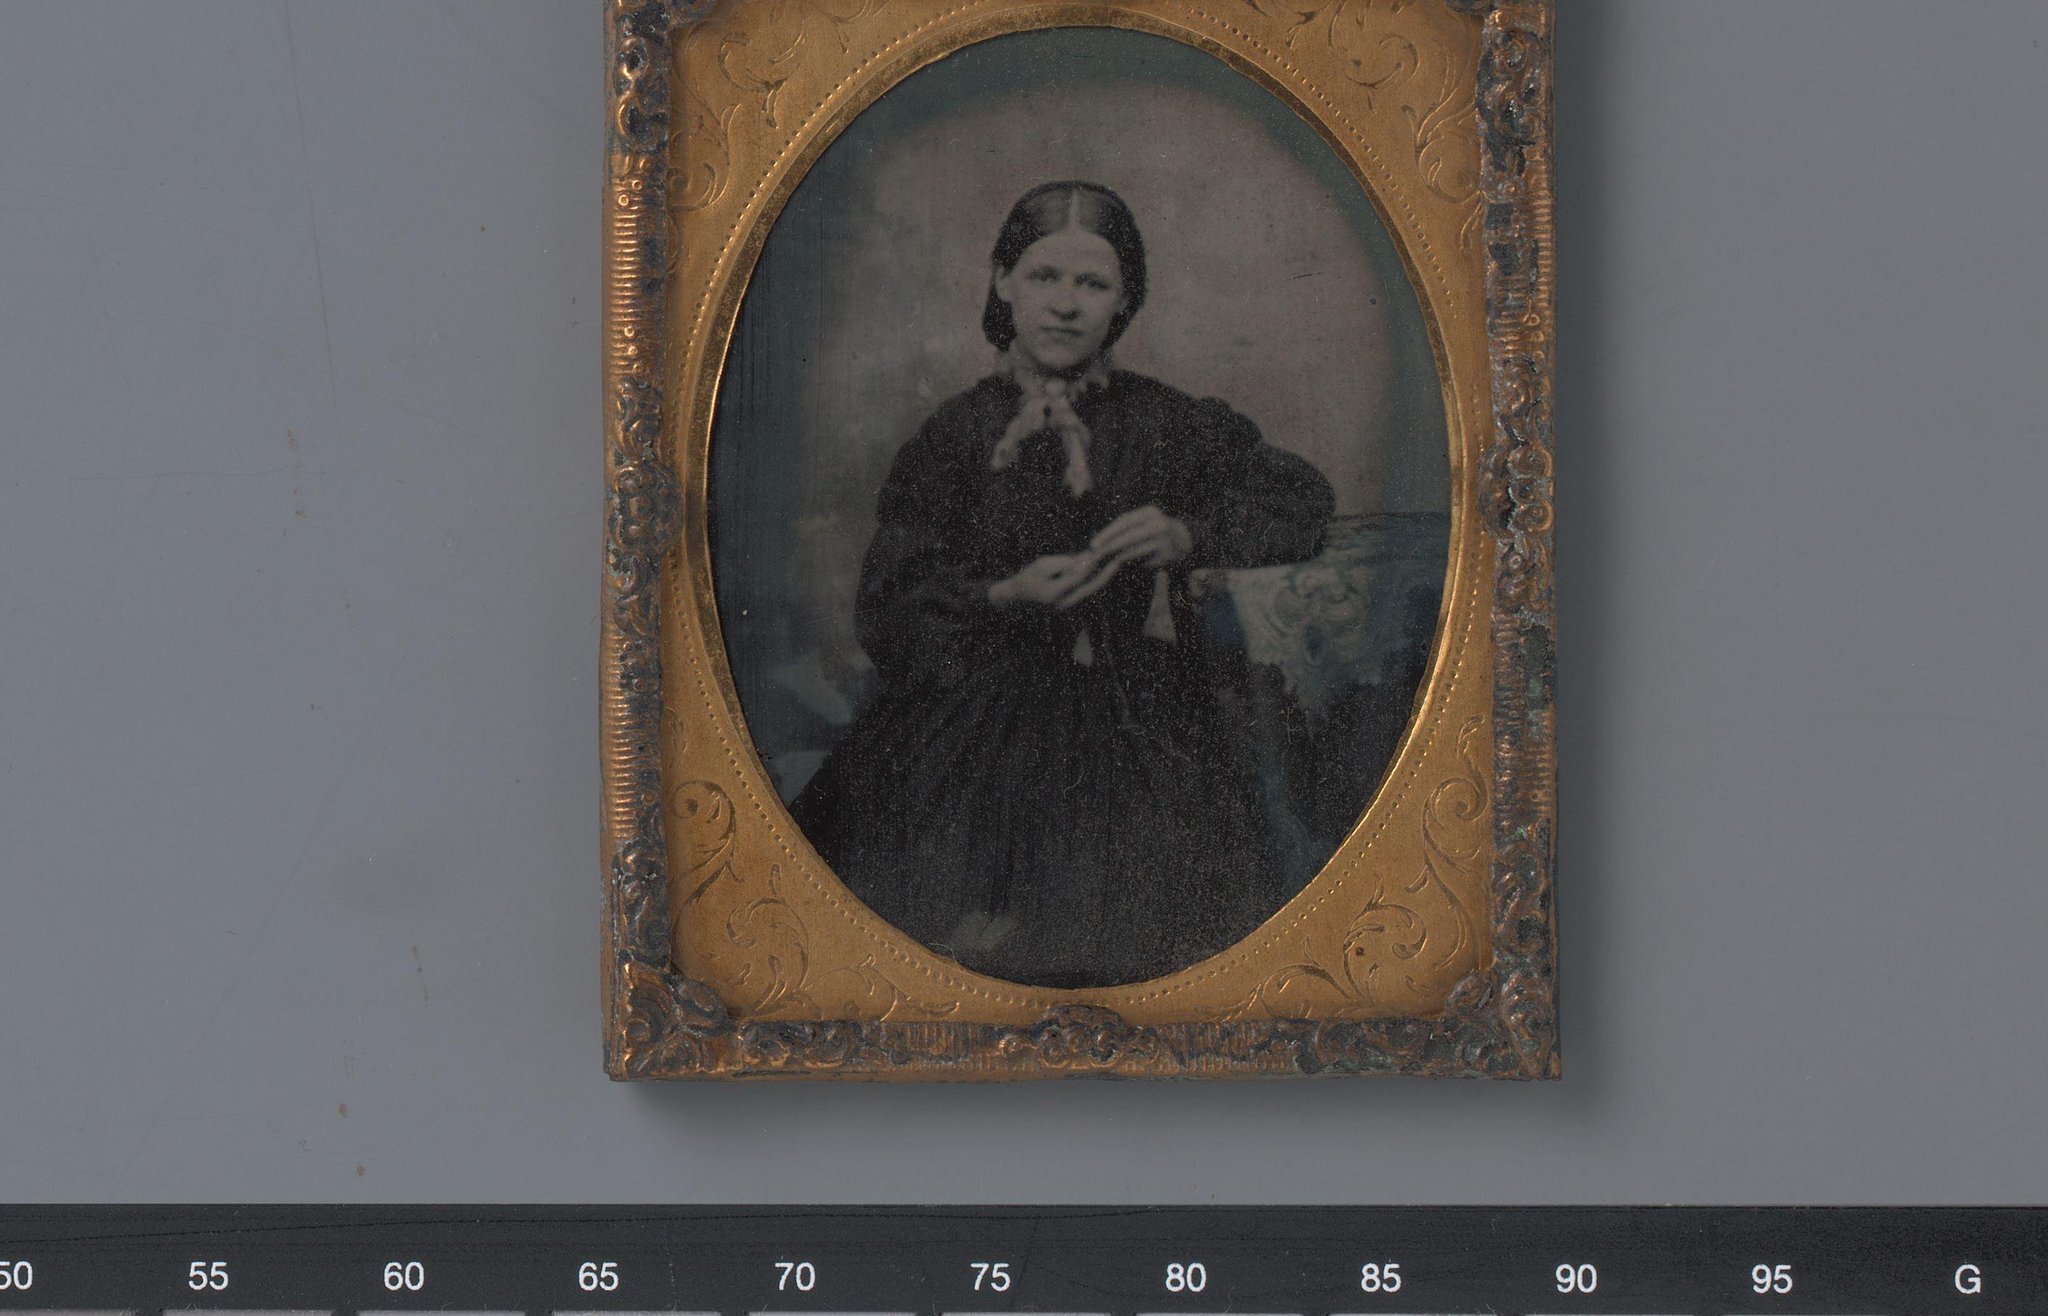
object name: photograph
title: Portret van een vrouw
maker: Anonymous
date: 1855-1870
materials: glass, metal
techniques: ambrotype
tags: adult man, historical persons